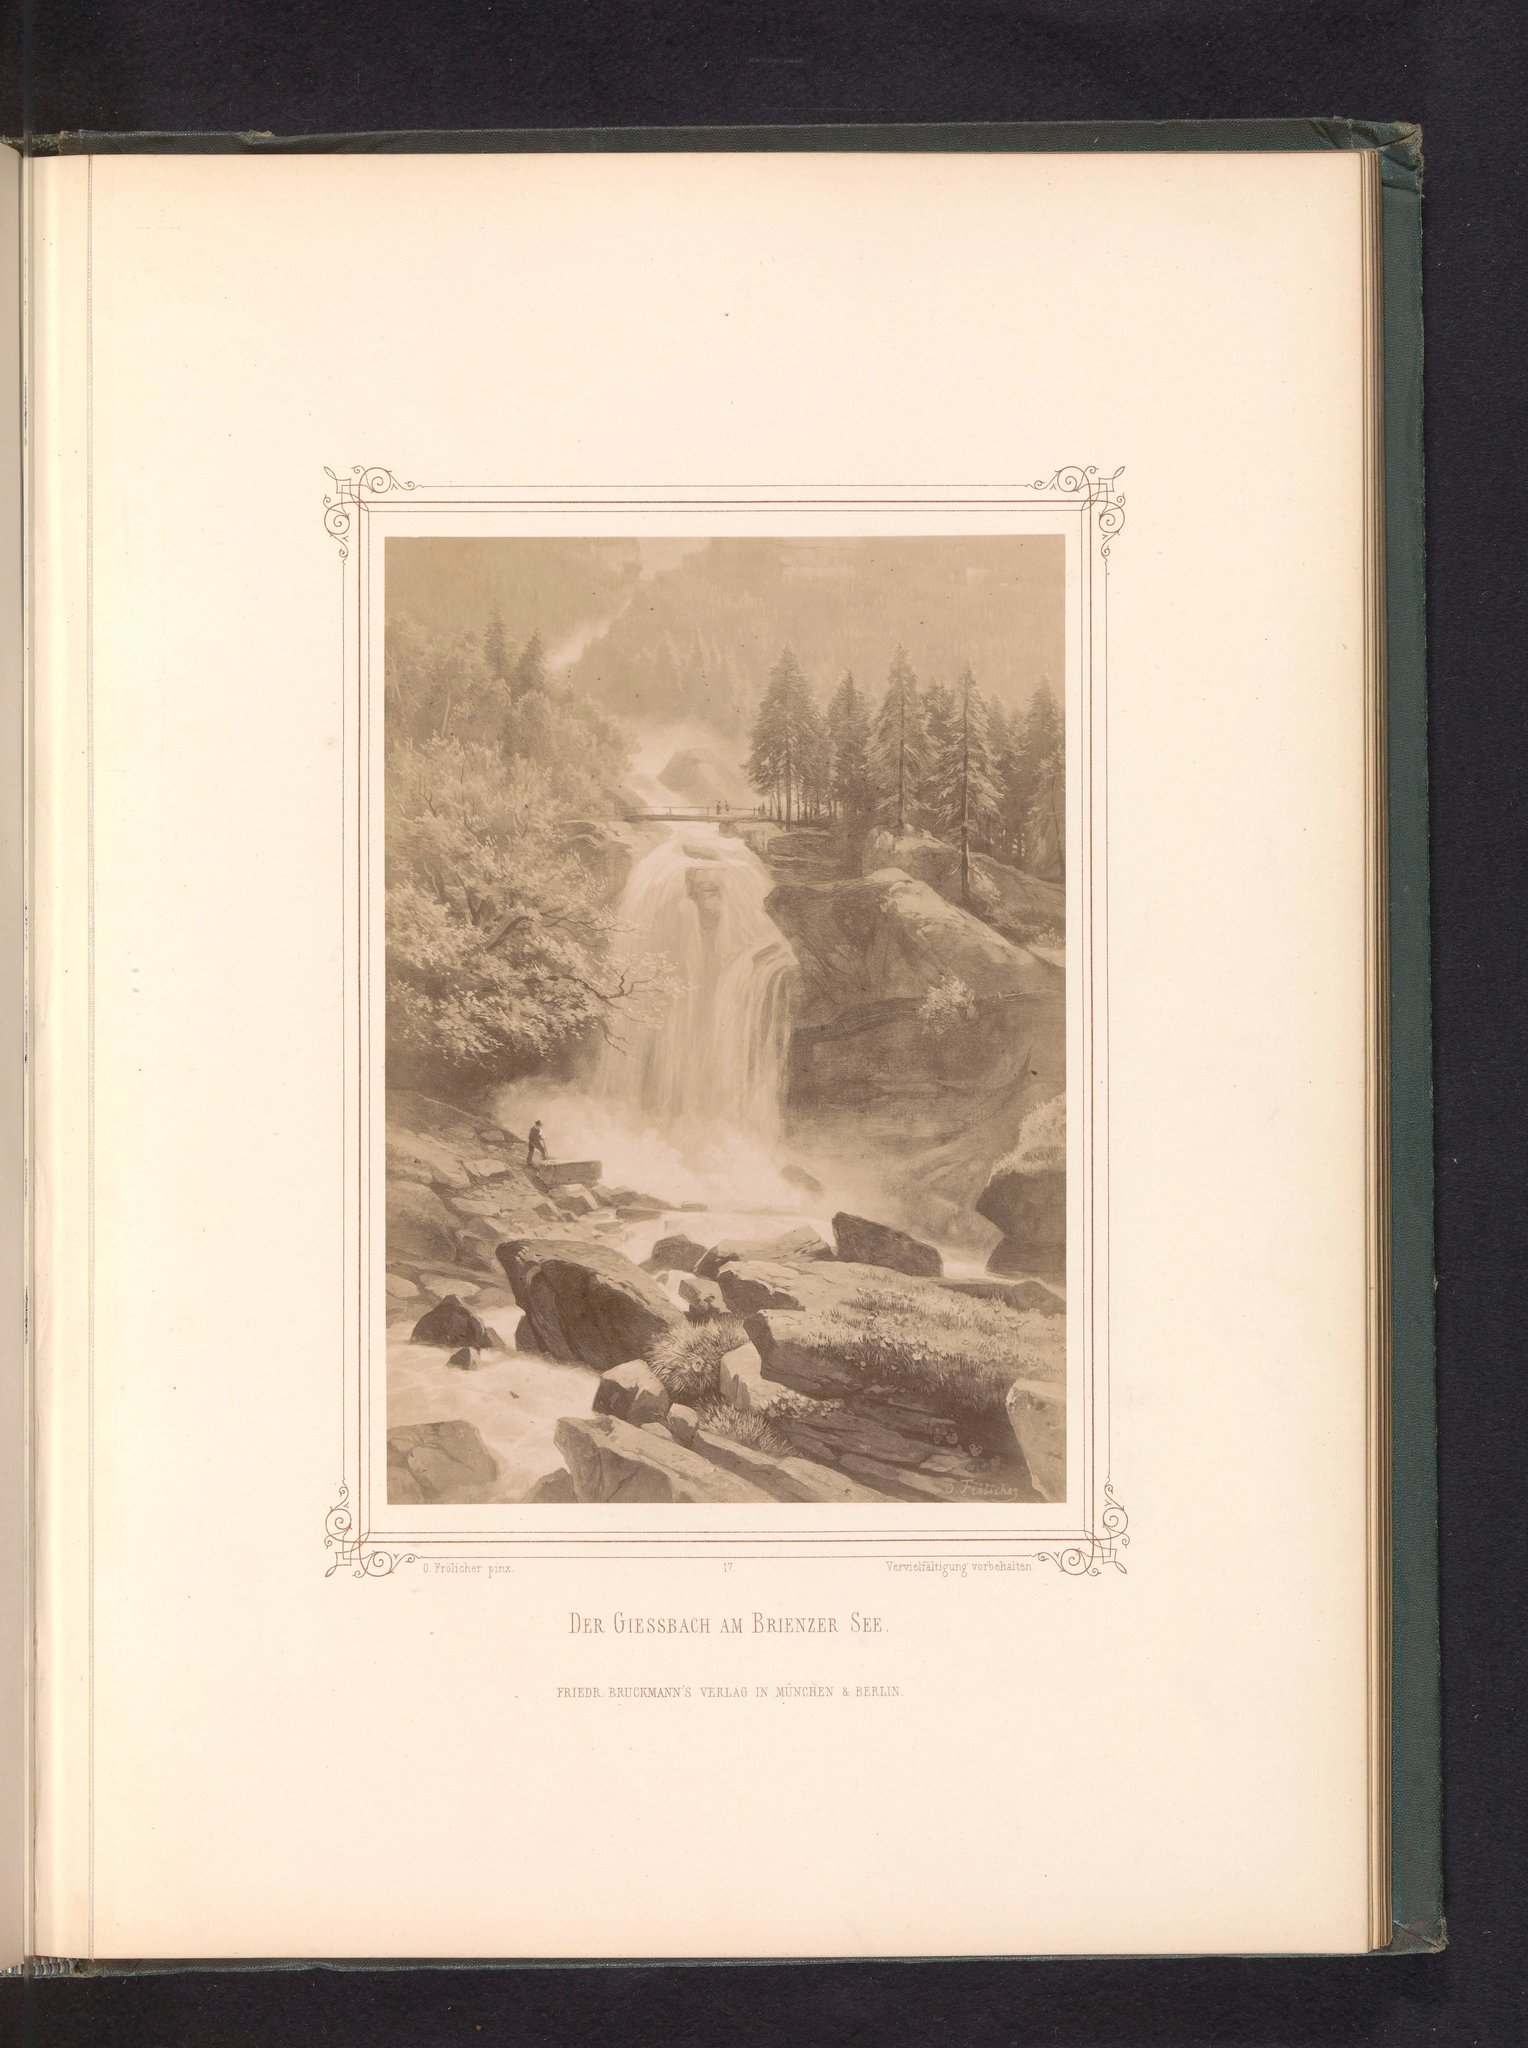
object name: photograph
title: Fotoreproductie van een schilderij van een gezicht op de Giessbachwaterval aan het Meer van Brienz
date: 1863-1873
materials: photographic support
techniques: albumen print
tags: waterfall, mountains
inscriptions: number: ‘17.’